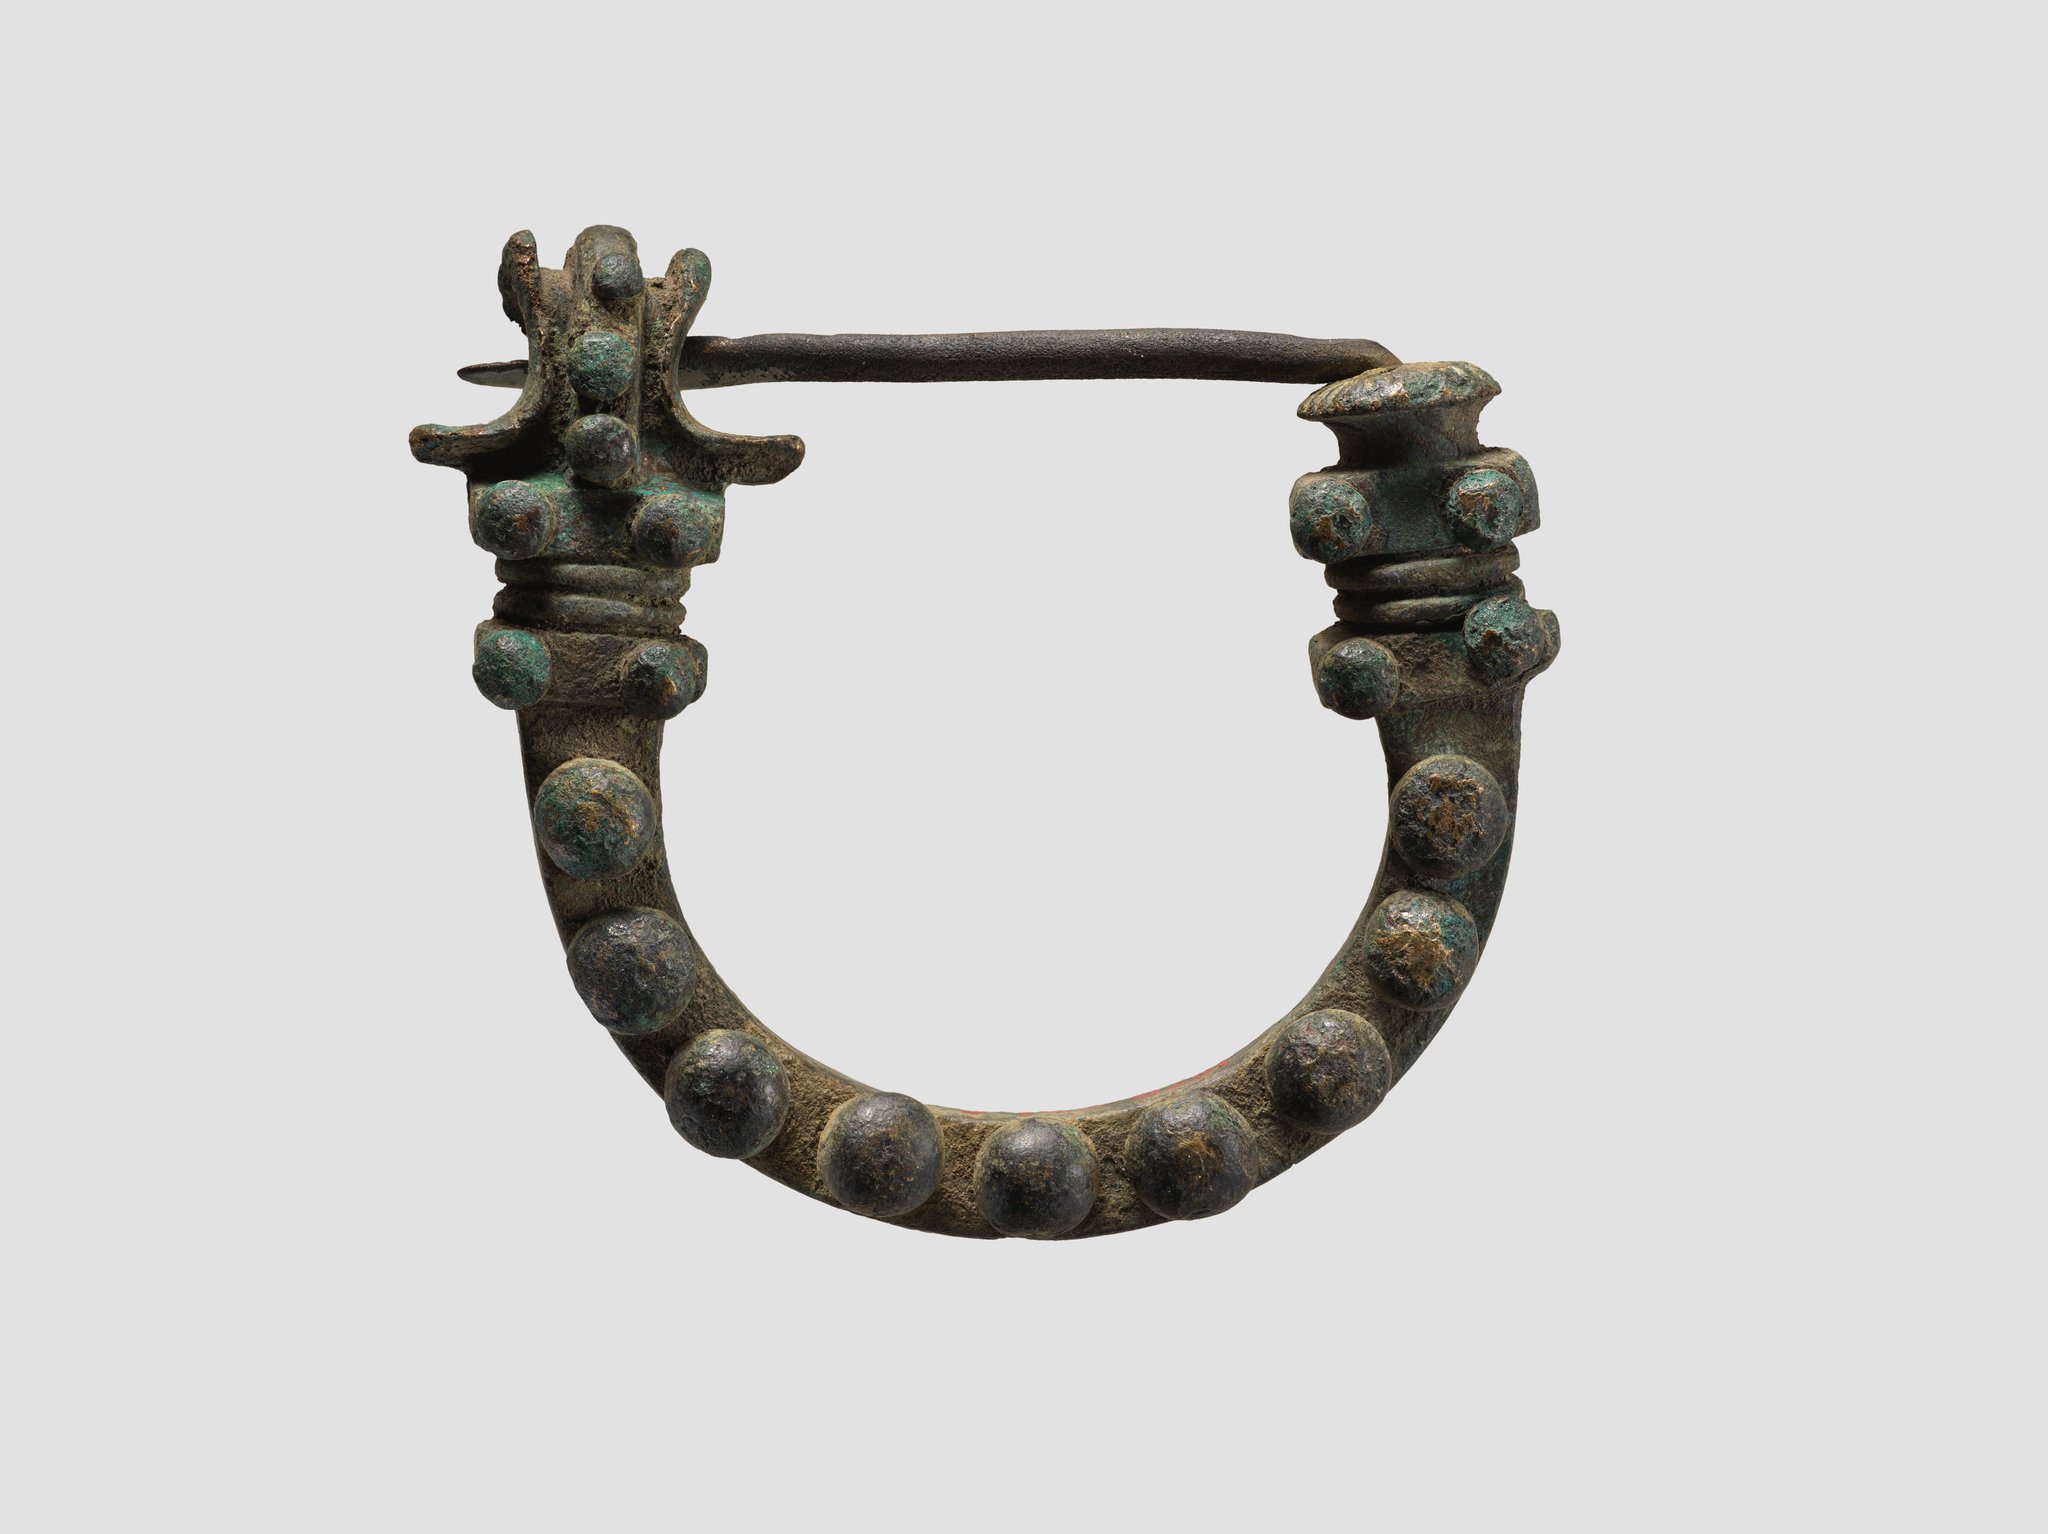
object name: fibula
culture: phrygian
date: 800-601 BCE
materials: bronze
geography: phrygia